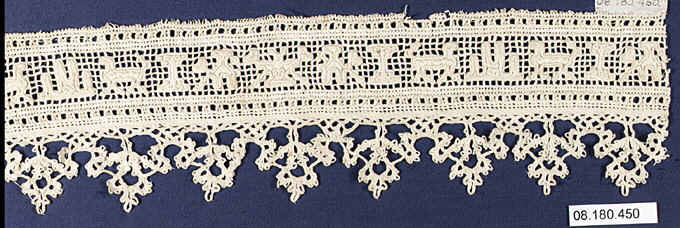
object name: border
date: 1501-1600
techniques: embroidery